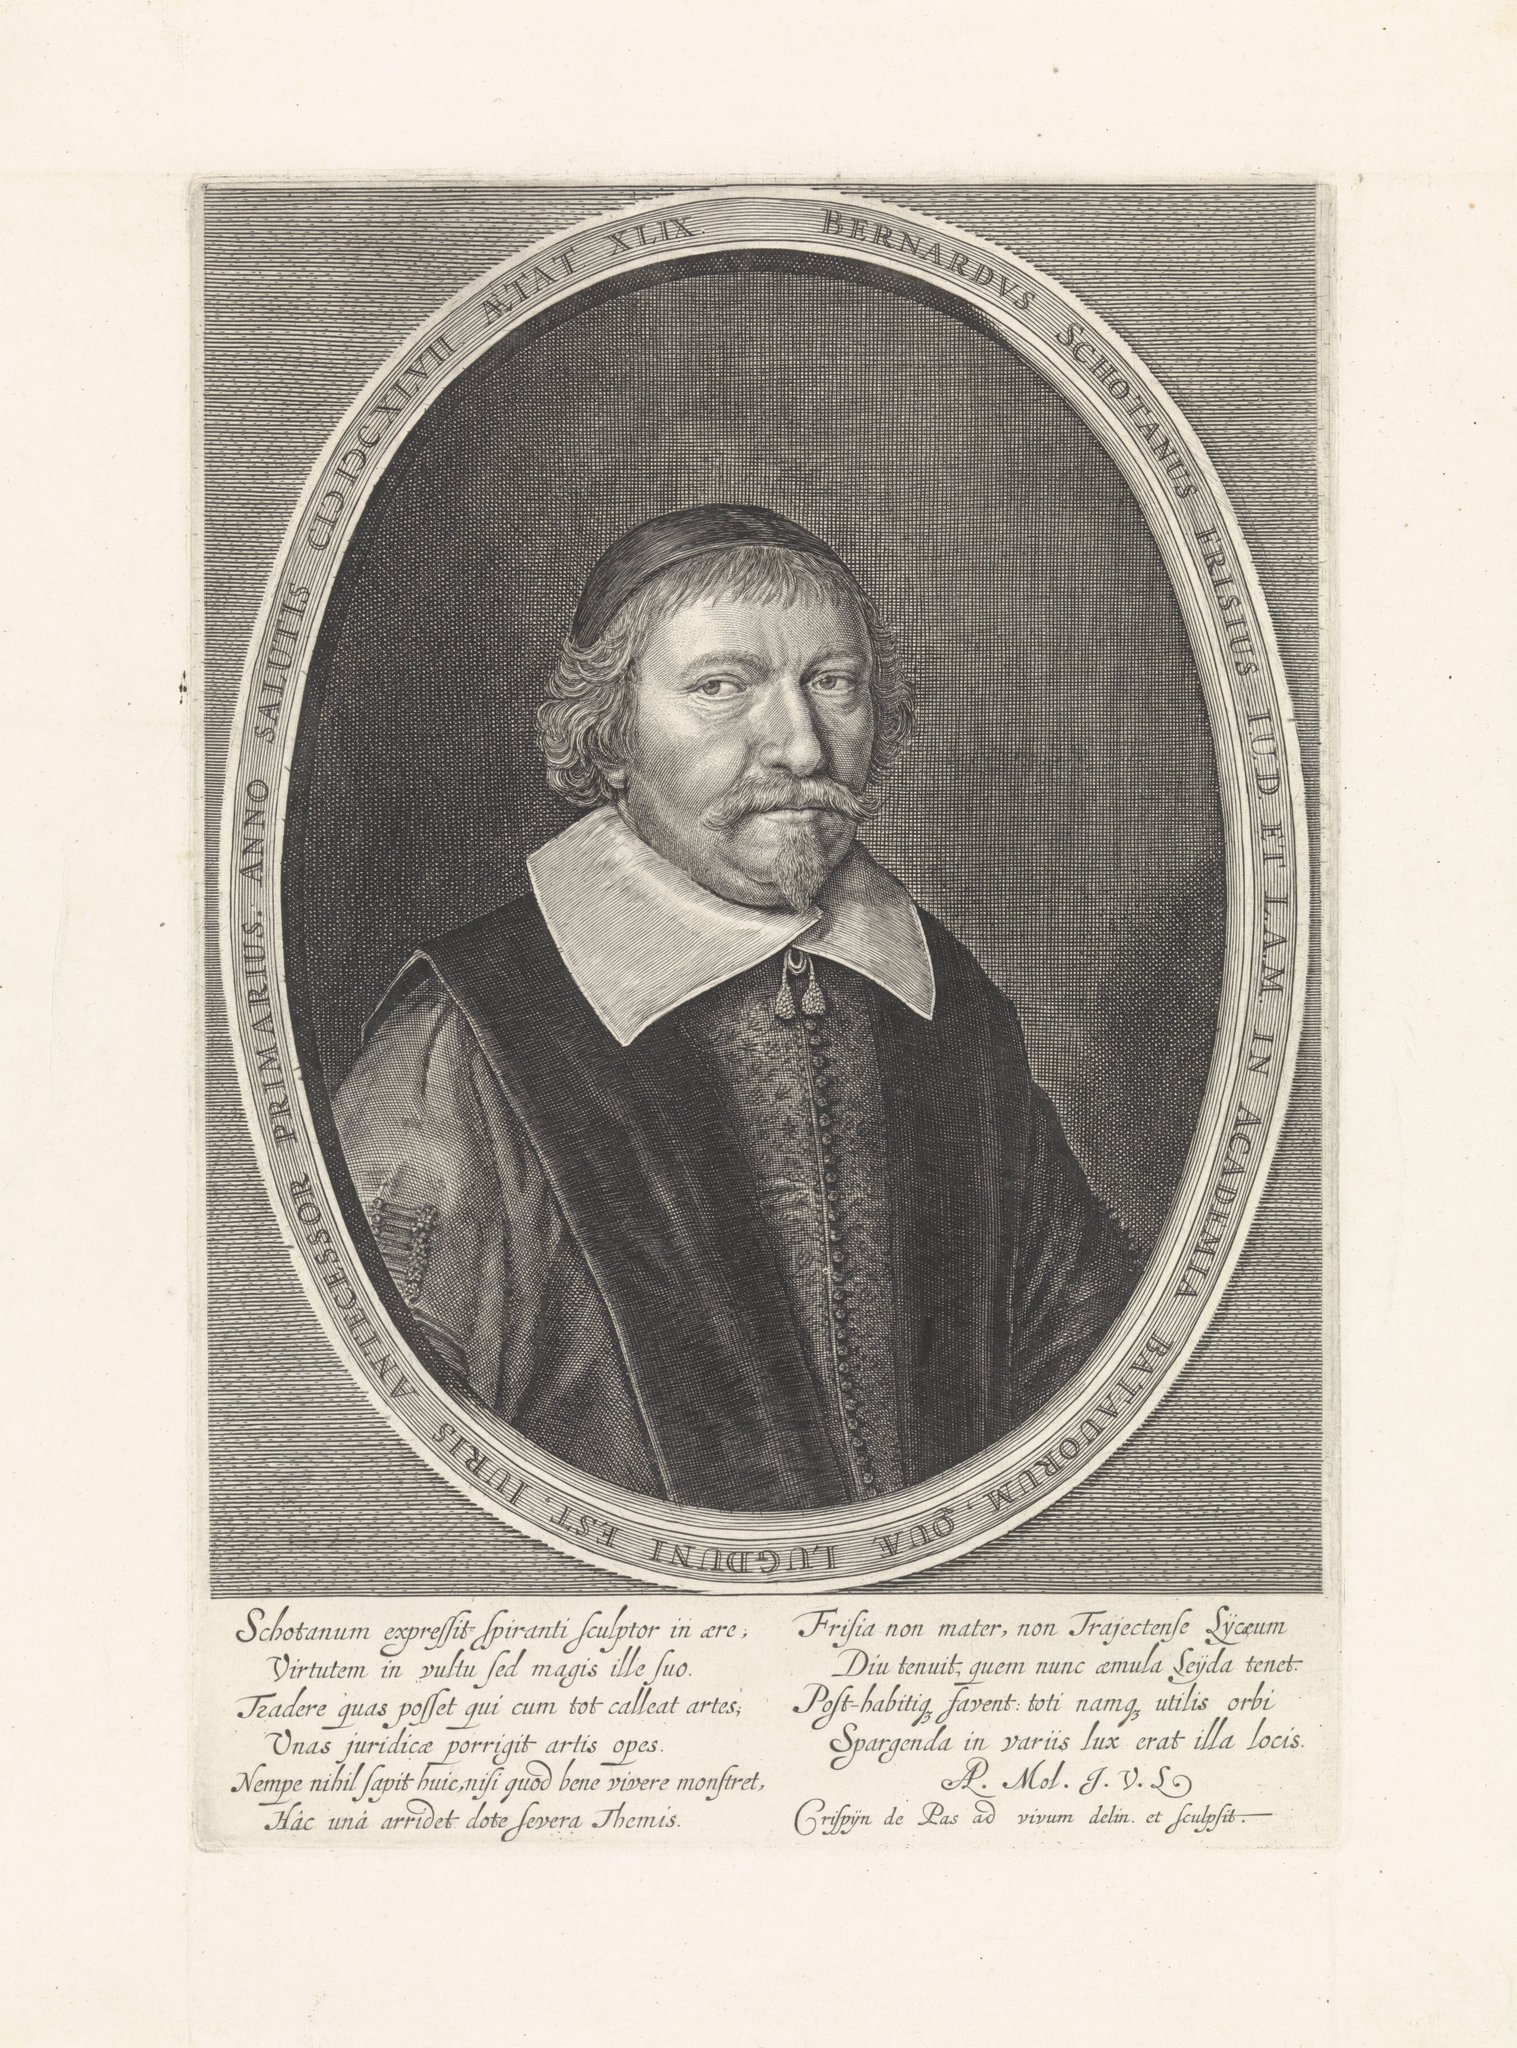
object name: print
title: Portret van Bernardus Schotanus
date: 1647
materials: paper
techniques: engraving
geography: amsterdam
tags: bernardus schotanus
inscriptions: collector's mark: Lugt 240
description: Portret van de Leidse hoogleraar Bernardus Schotanus, op 49-jarige leeftijd. In de marge een tienregelig lofdicht, in twee kolommen, in het Latijn.